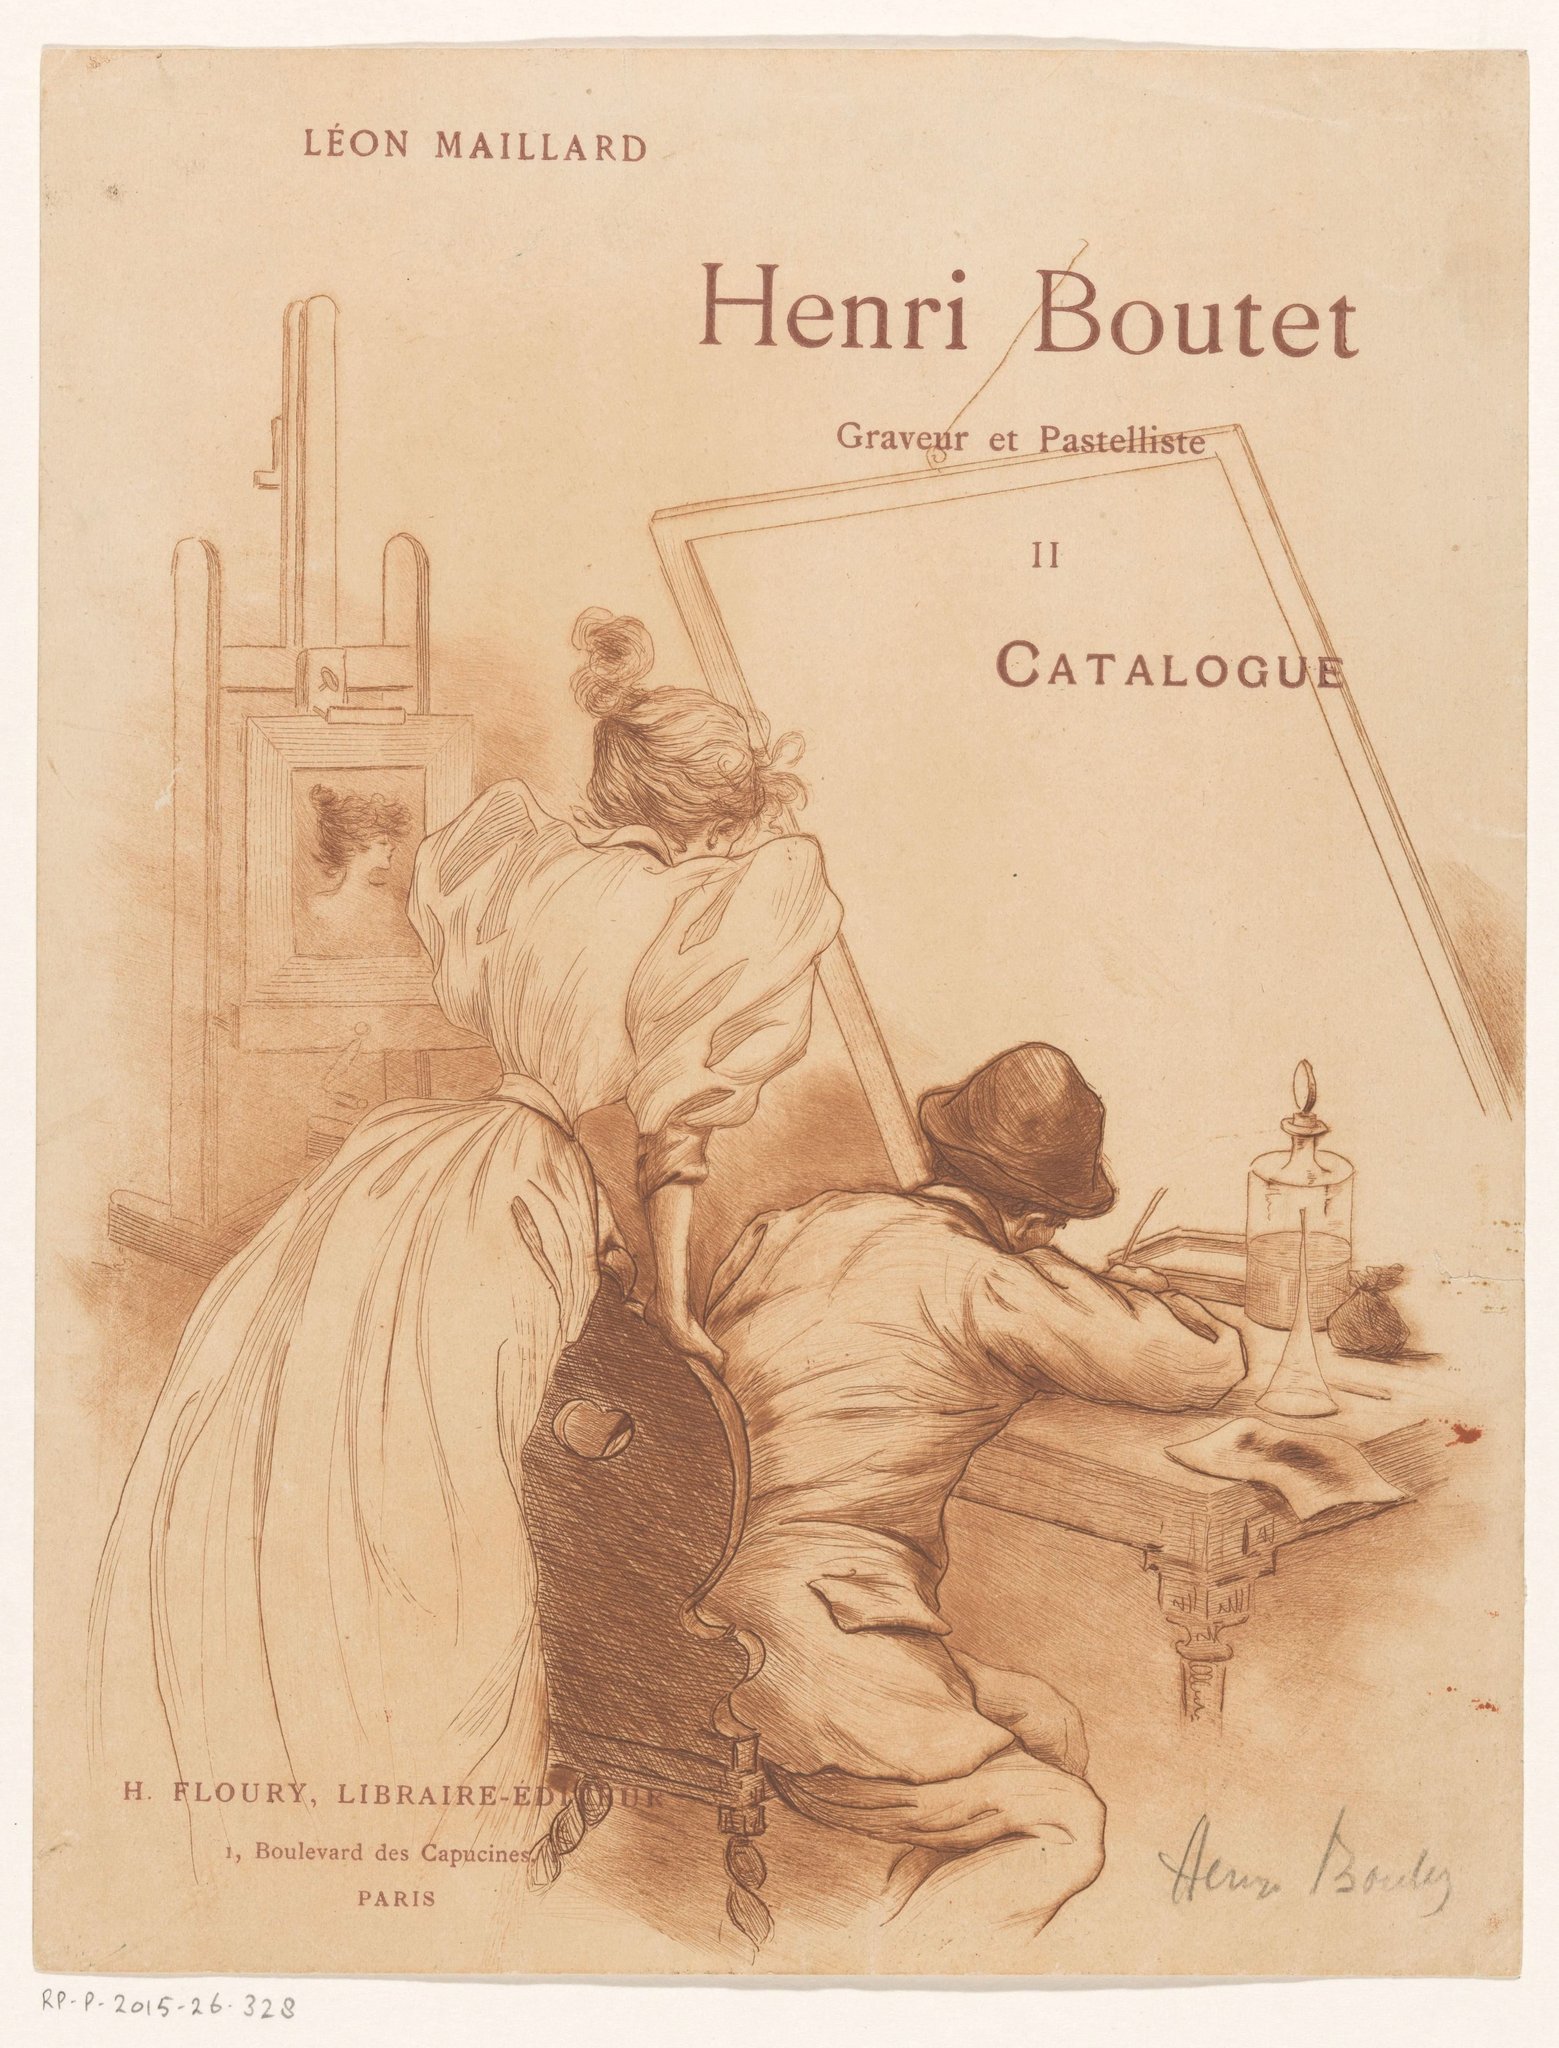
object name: print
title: Prentmaker achter zijn werktafel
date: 1894-1895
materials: paper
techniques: drypoint, letterpress printing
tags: artist at work, in his workshop (+ graphic arts), easel, workshop, studio of the artist (in general), graphic artist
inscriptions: collector's mark: Lugt 4779, annotation: ‘Henri Boutet’, collector's mark: Lugt 2228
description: Een prentmaker achter zijn werktafel, een vrouw kijkt mee over zijn schouder, beiden op de rug gezien. In de achtergrond een ezel met het portret van een vrouw.